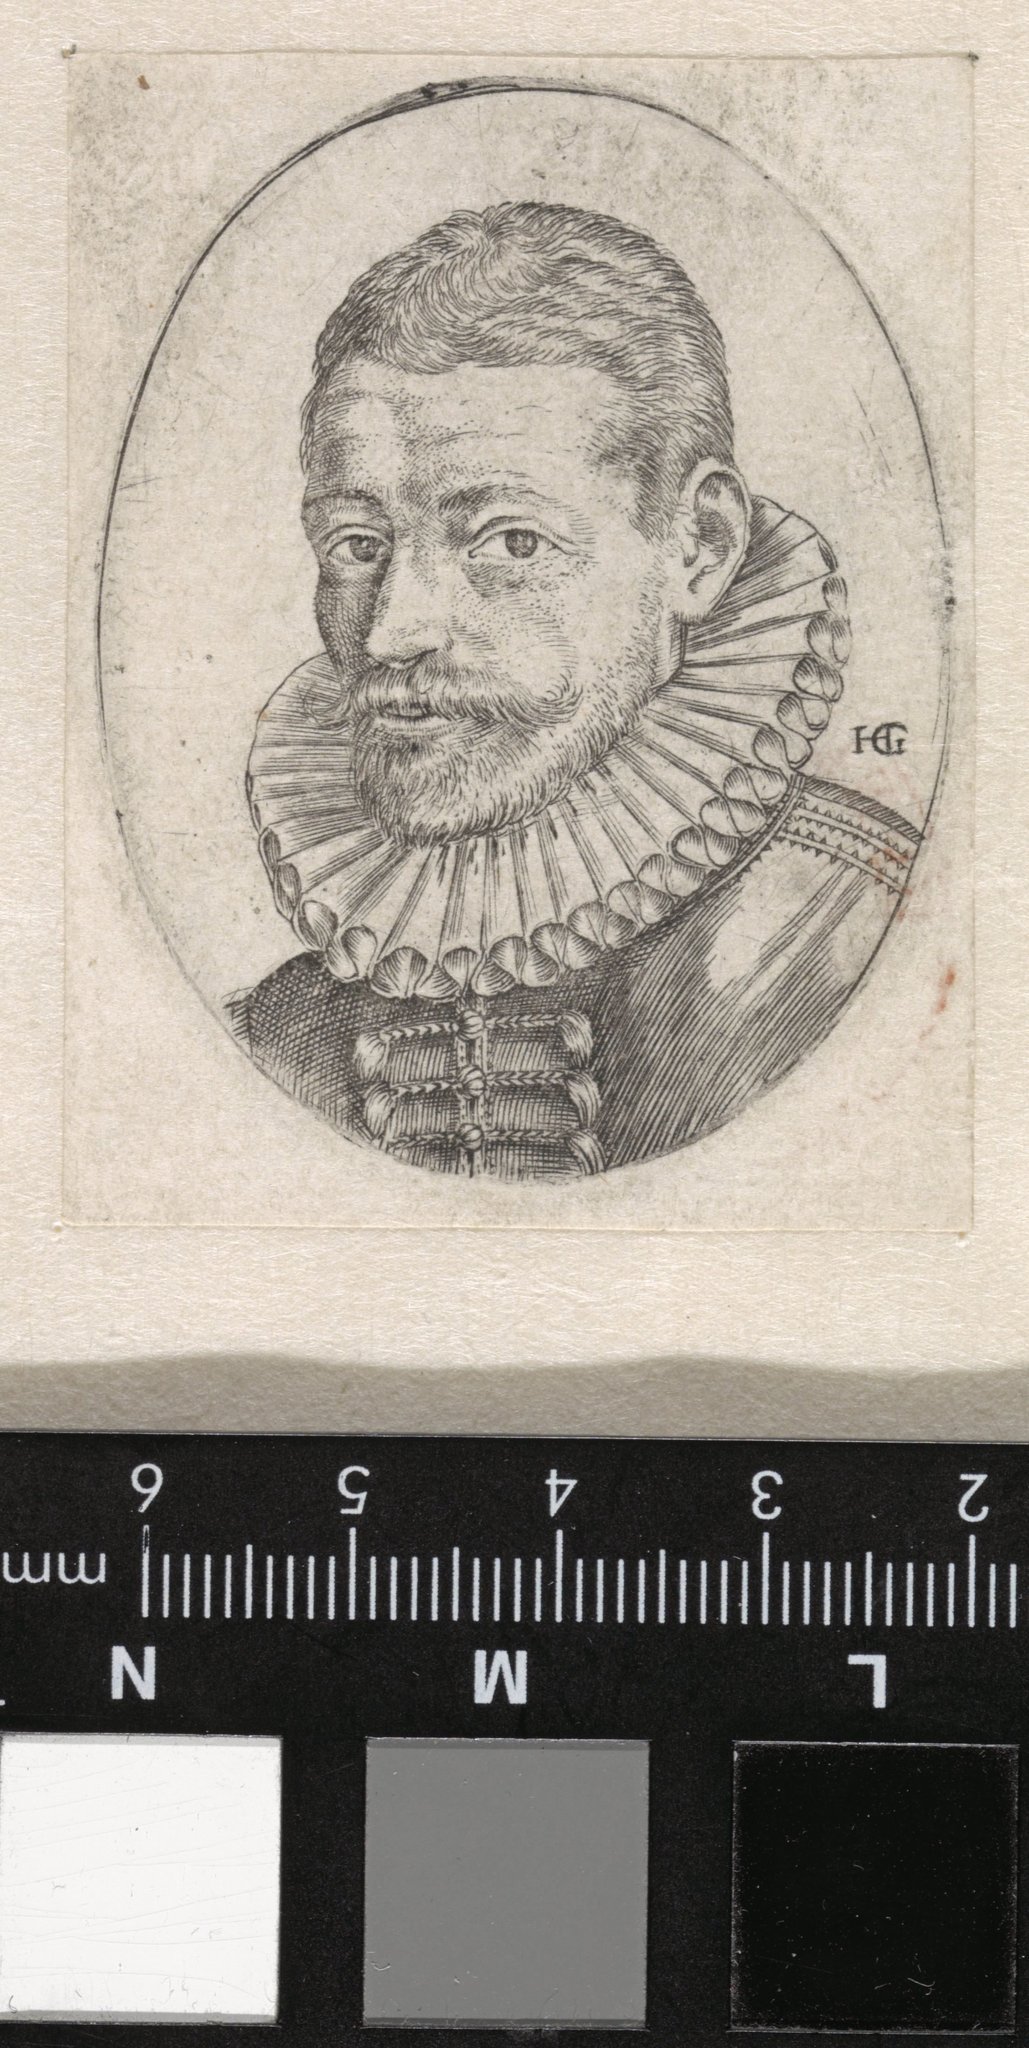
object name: print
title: Portret van koopman Hans Felbier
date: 1582-1667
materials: paper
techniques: engraving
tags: hamburg, hans felbier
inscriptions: collector's mark: Lugt 240